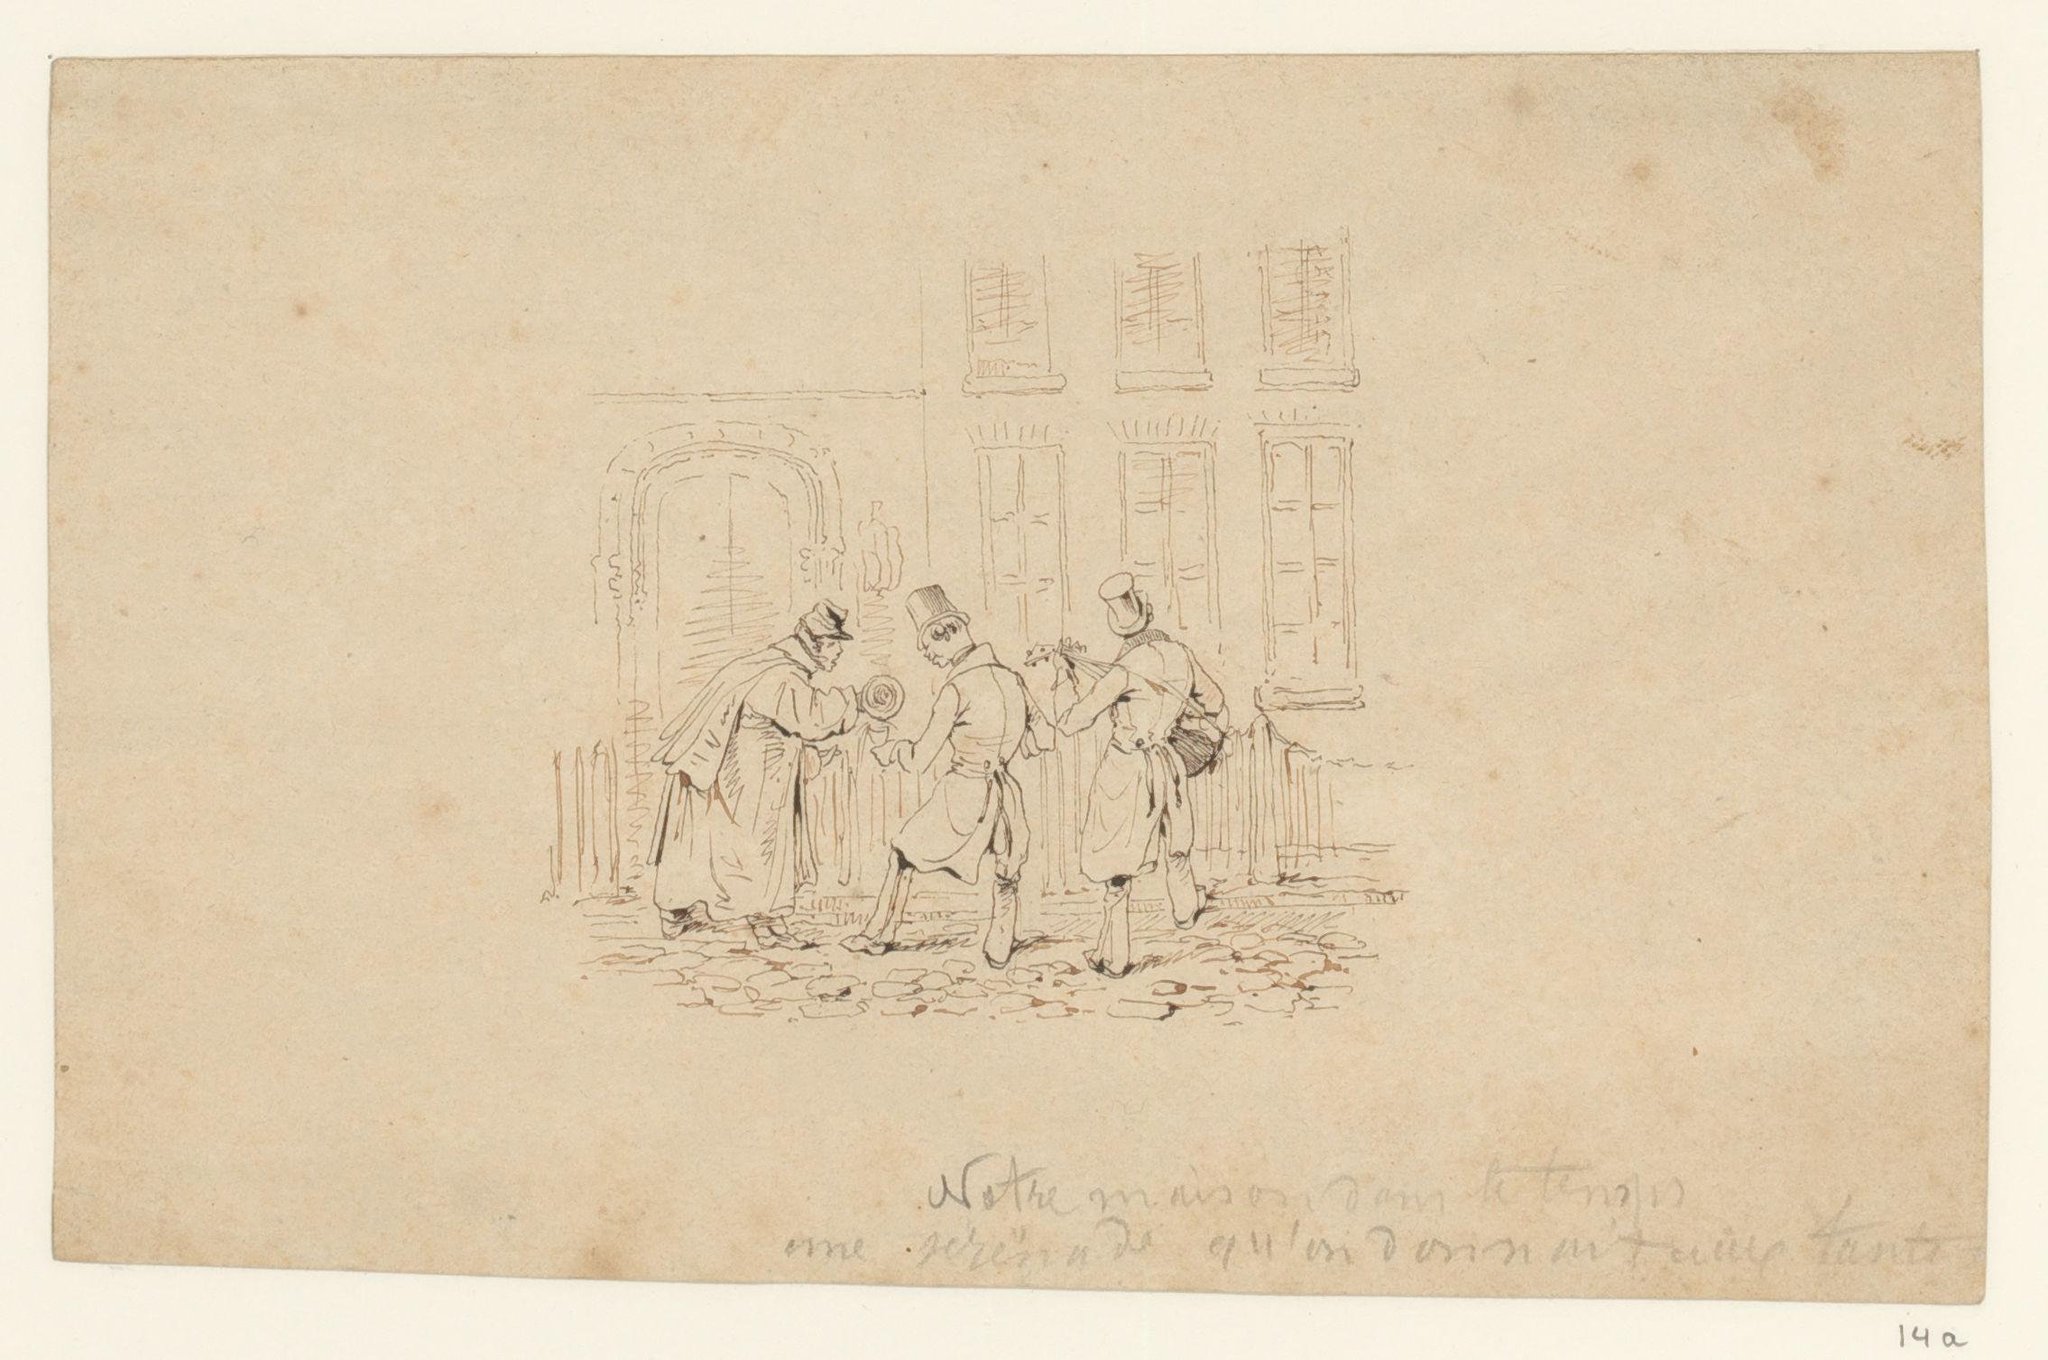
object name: drawing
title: Une serenade qu'on donnait aux tantes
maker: Anonymous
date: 1800-1880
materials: ink, paper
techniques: pen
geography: netherlands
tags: instrumental and vocal music together, carousal, drinking-bout, orgy, vocal popular music, cithern, mandolin, guitar, balalaika, private festivities, merry company, serenade to the beloved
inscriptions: stamp, collector's mark: Lugt 1641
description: Drie mannen brengen op straat een serenade voor een huis met gesloten ramen. Een man speelt gitaar, de andere twee schenken een glas drinken uit een fles. Onderwerpsrubrieken binnen de Atlas Zeden en Gewoonten: Muziek en muziekinstrumenten: Strijk- en snaarinstrumenten.